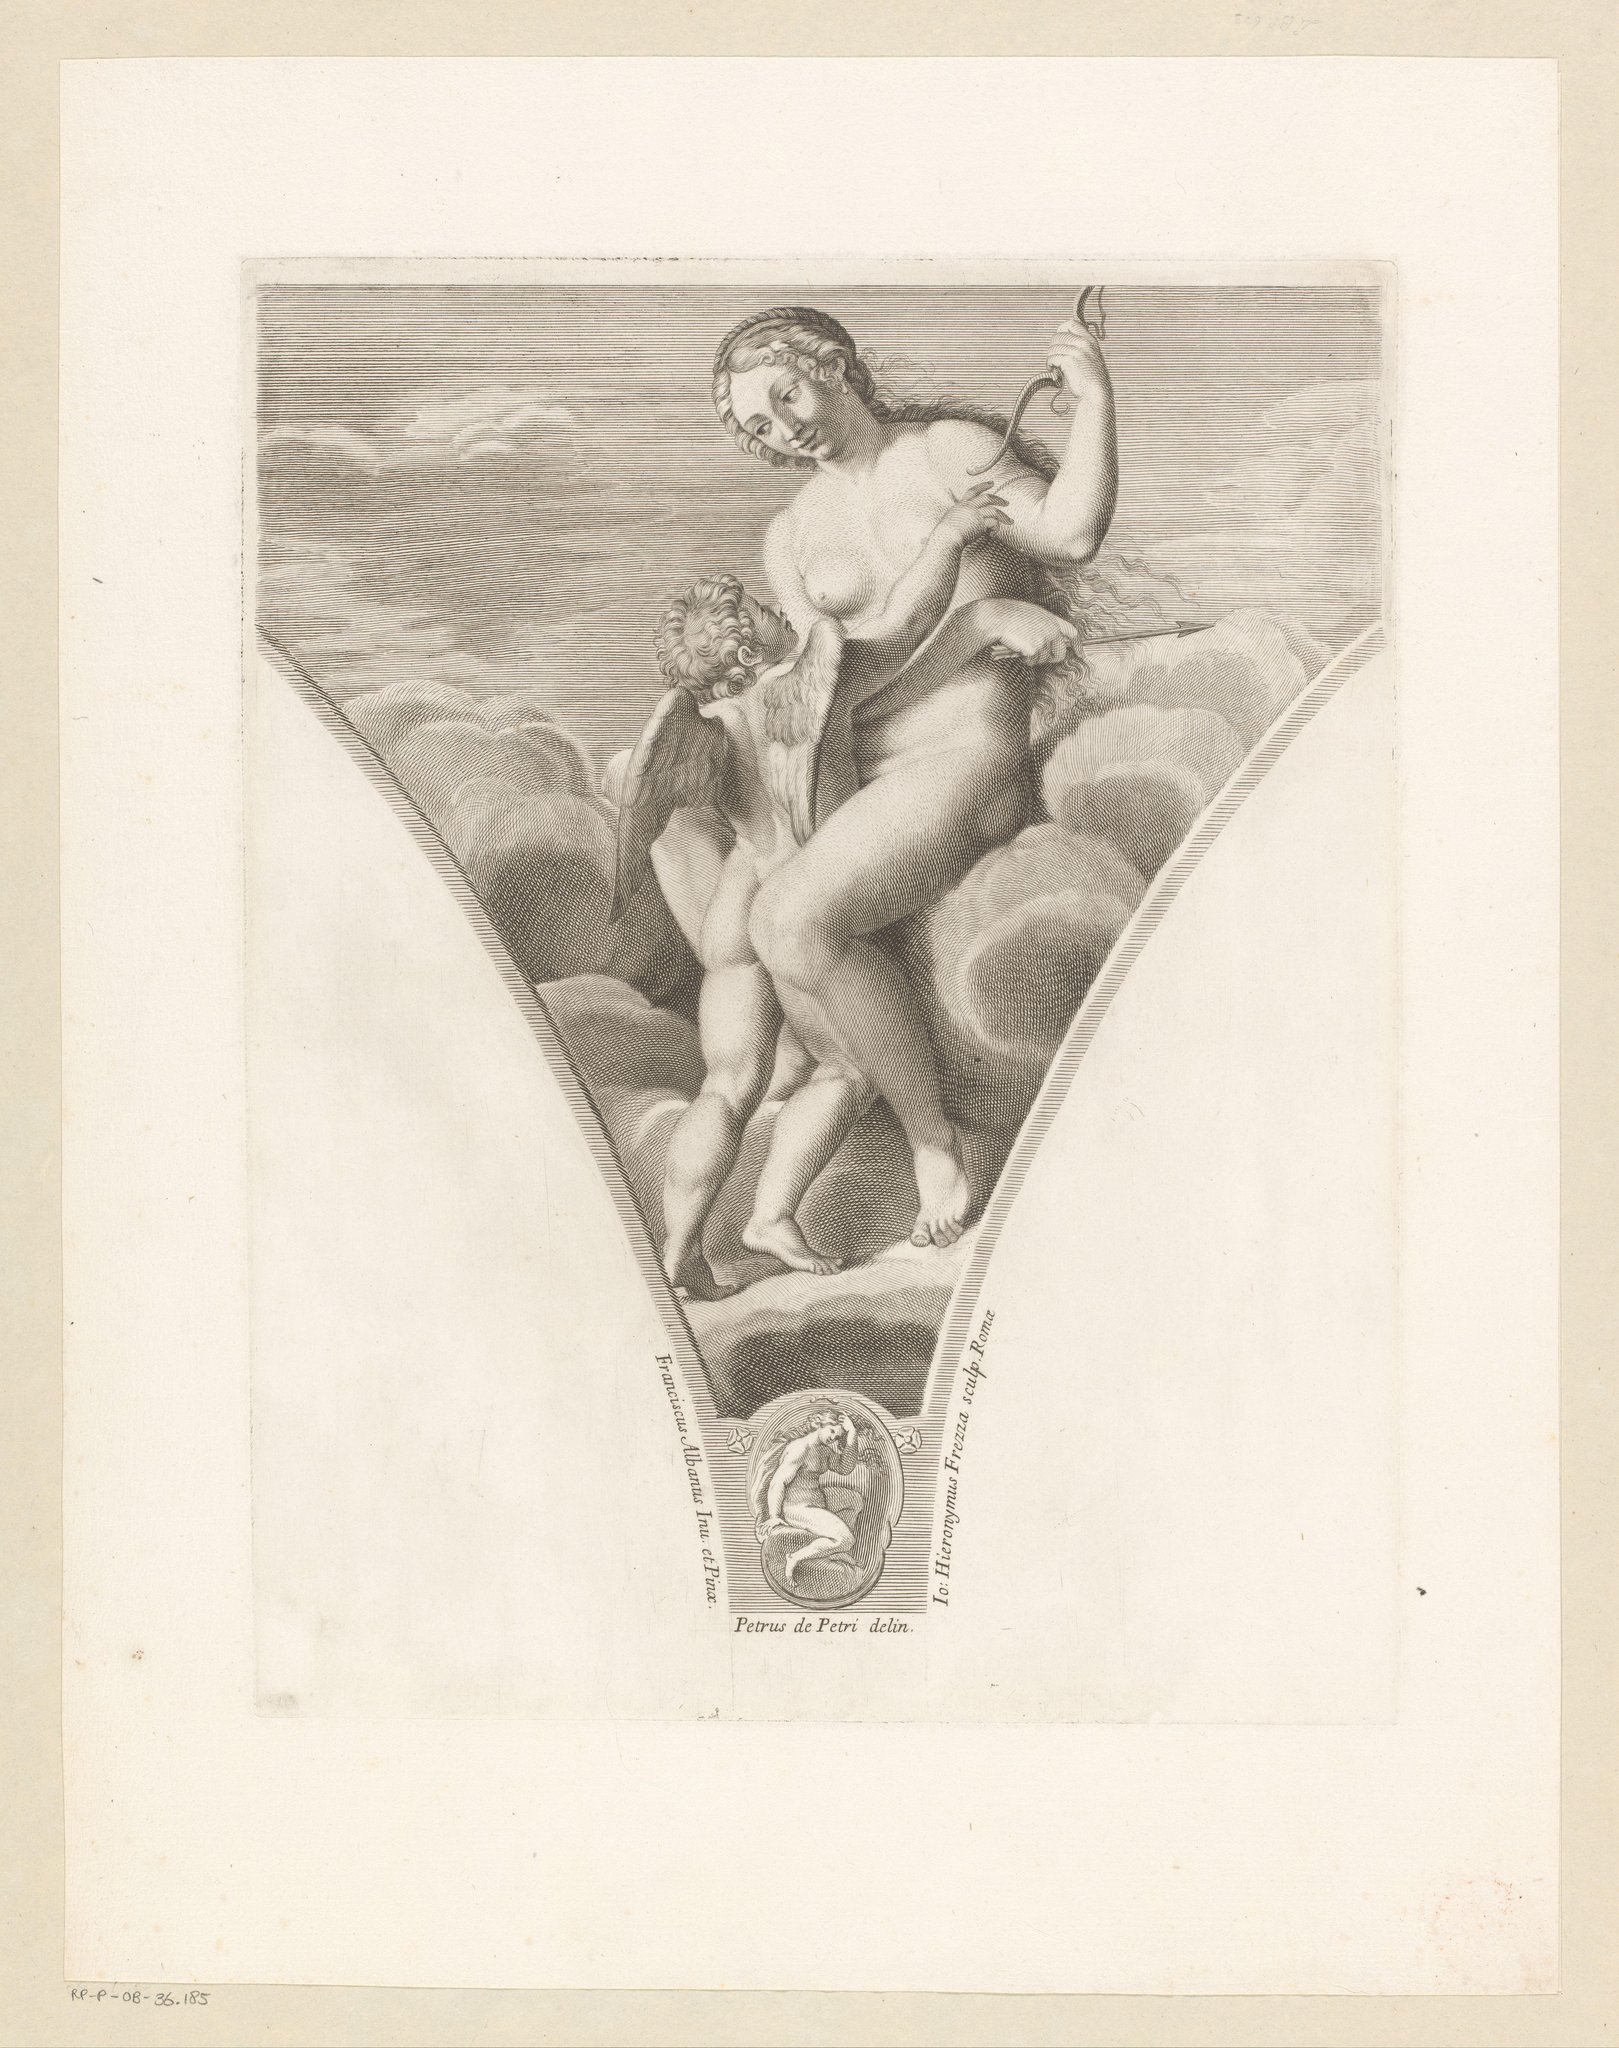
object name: print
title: Venus en Amor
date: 1704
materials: paper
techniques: engraving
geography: italy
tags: venus and cupid (cupid not being mere attribute)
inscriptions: collector's mark: Lugt 240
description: De godin Venus en Amor. Venus heeft de pijl en boog van Amor vast. Decoratie van een pendentief.